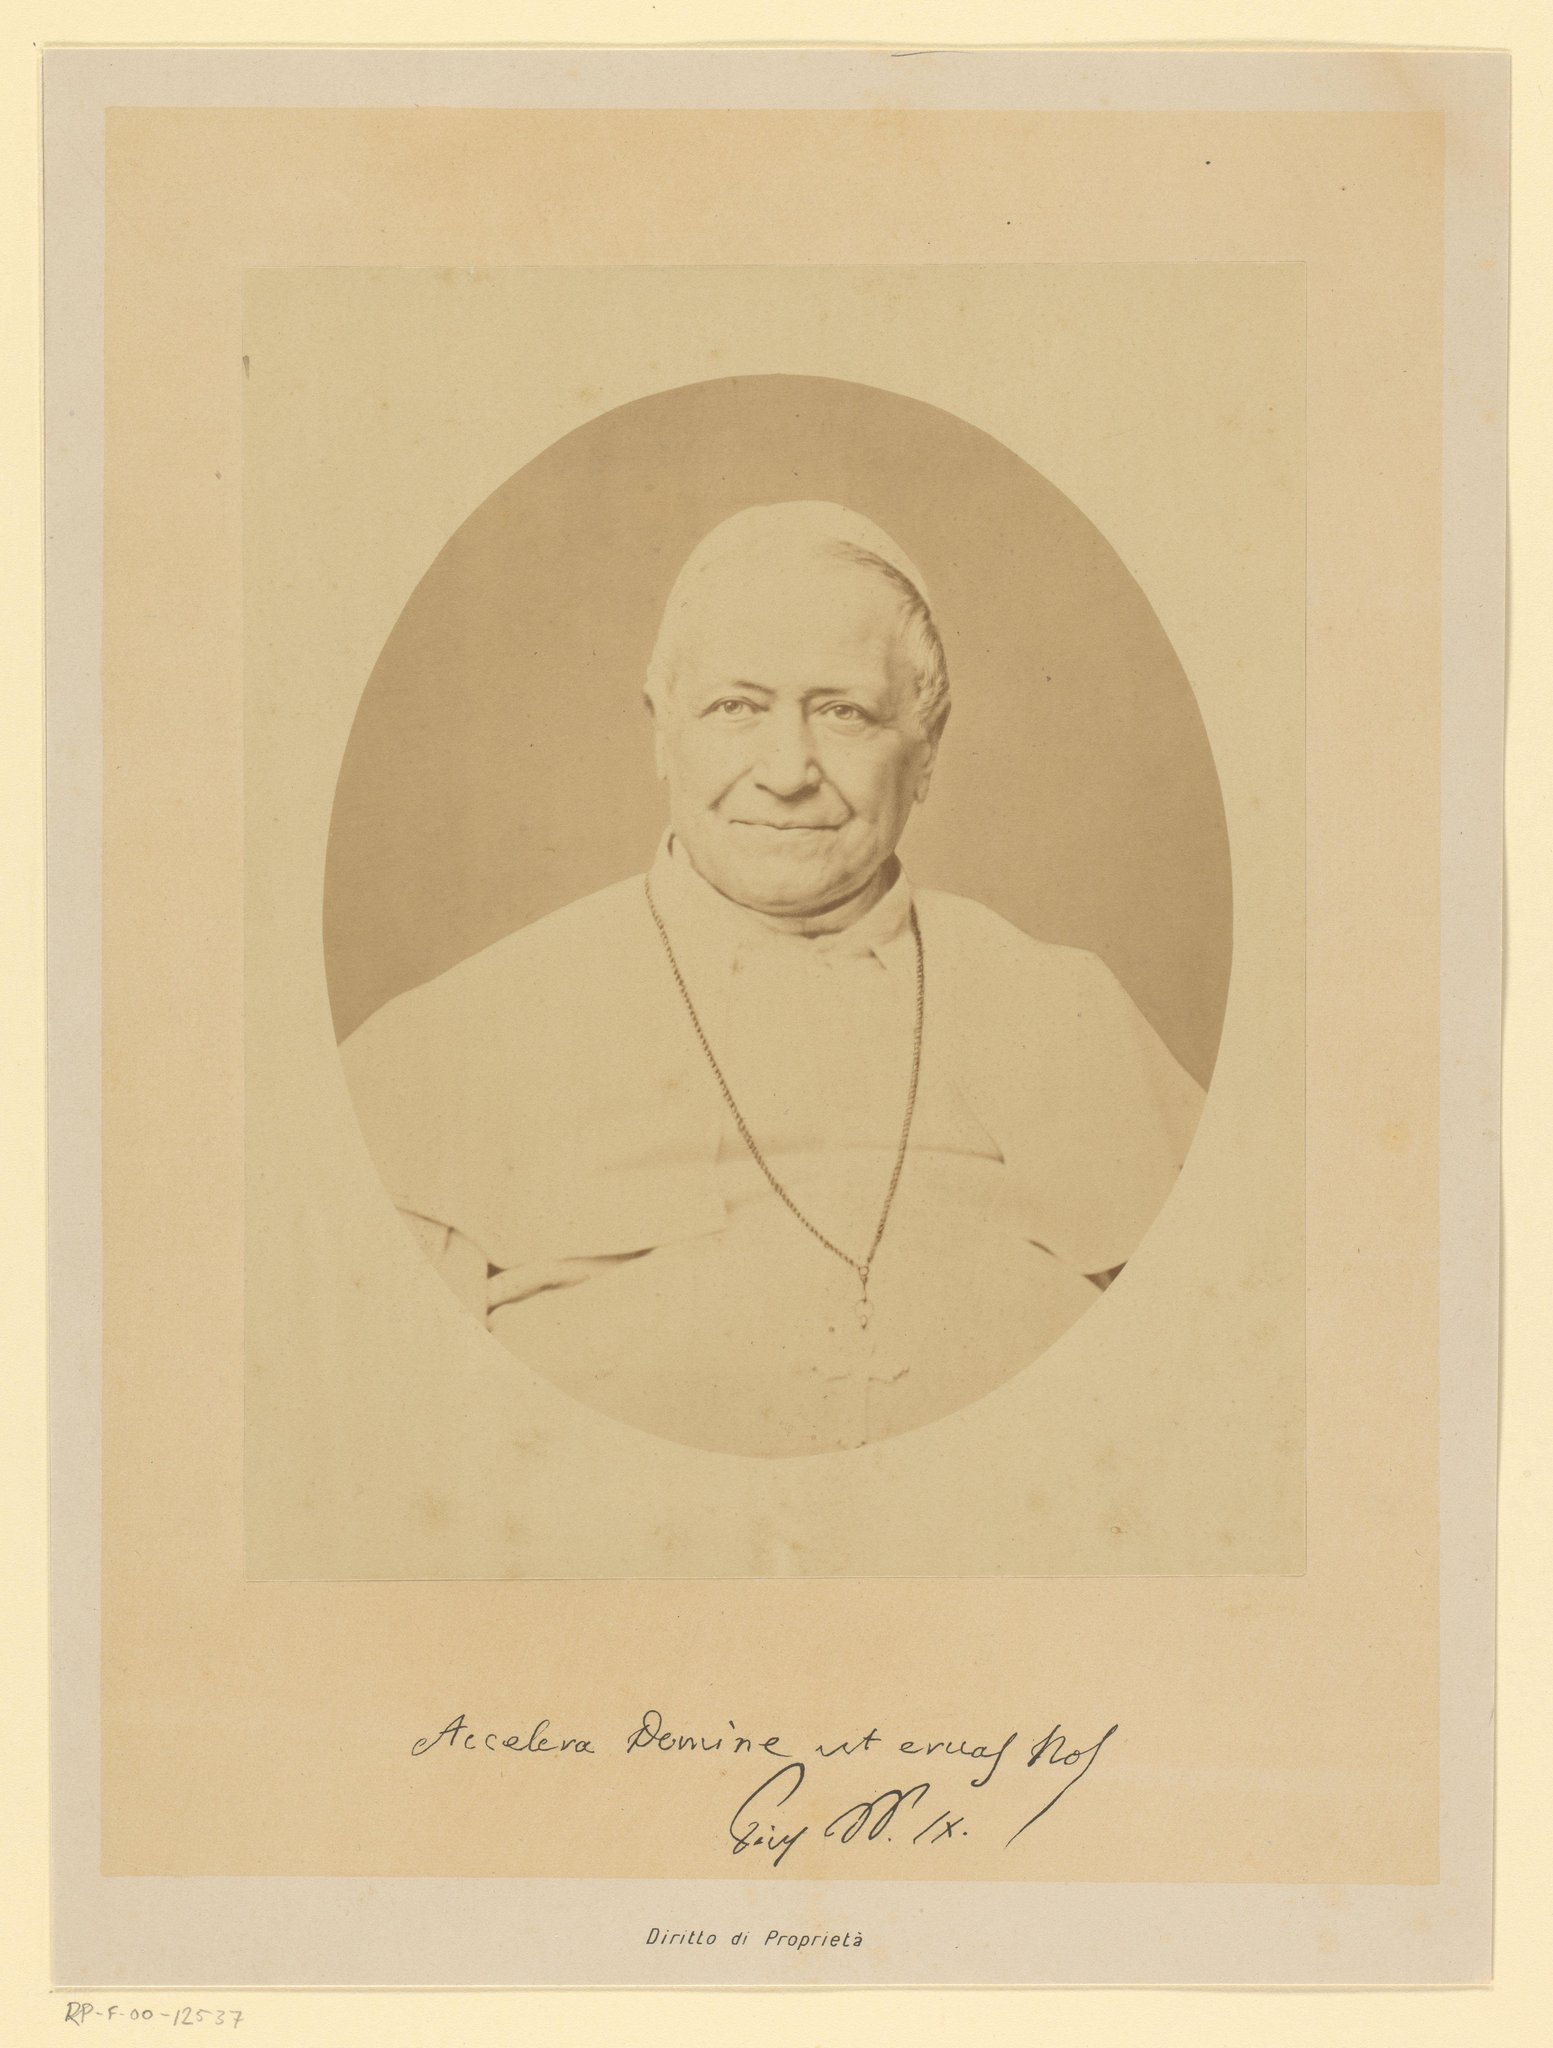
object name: photograph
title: Portret van paus Pius IX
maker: Anonymous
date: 1870-1878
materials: cardboard, paper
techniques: albumen print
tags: rome, historical persons, pope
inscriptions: signature: ‘Accelera Genuine ut eruas Nos/ Pius [...]. IX.’